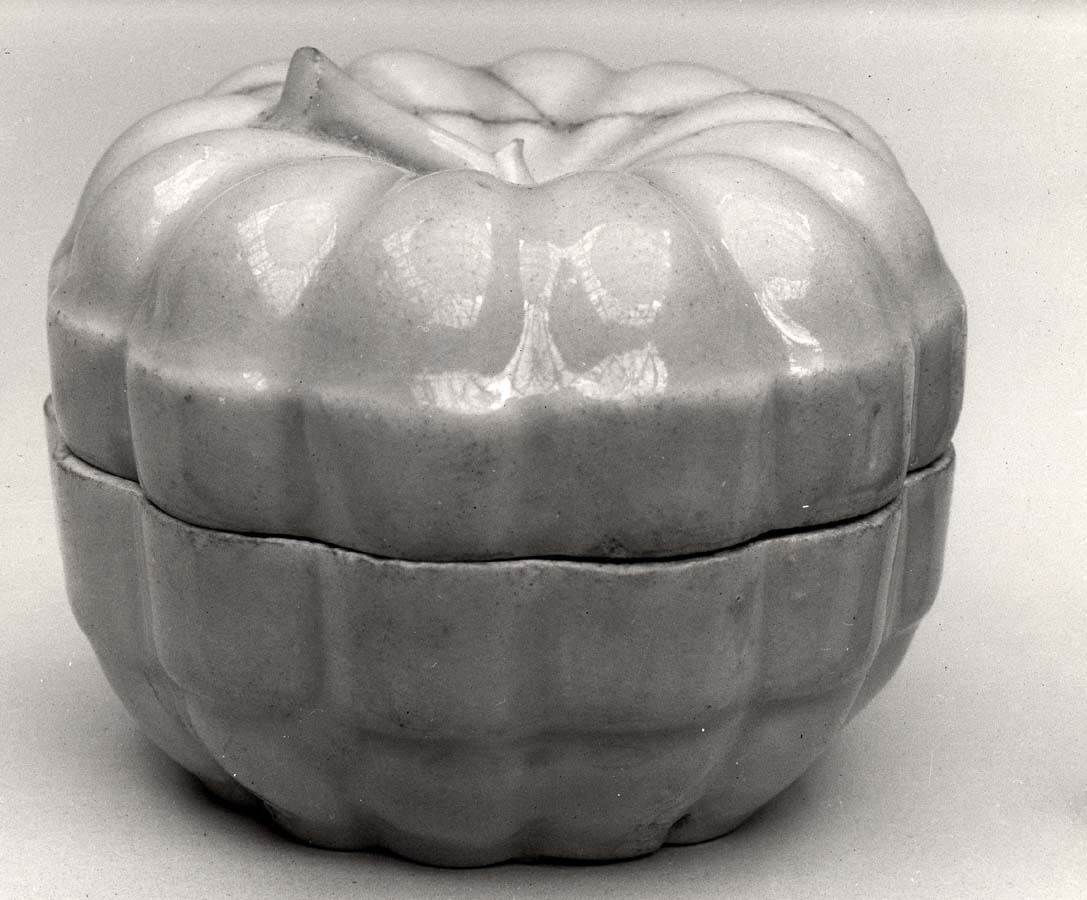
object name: box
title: Box in the shape of a melon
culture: chinese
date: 1001-1200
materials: glaze, porcelain